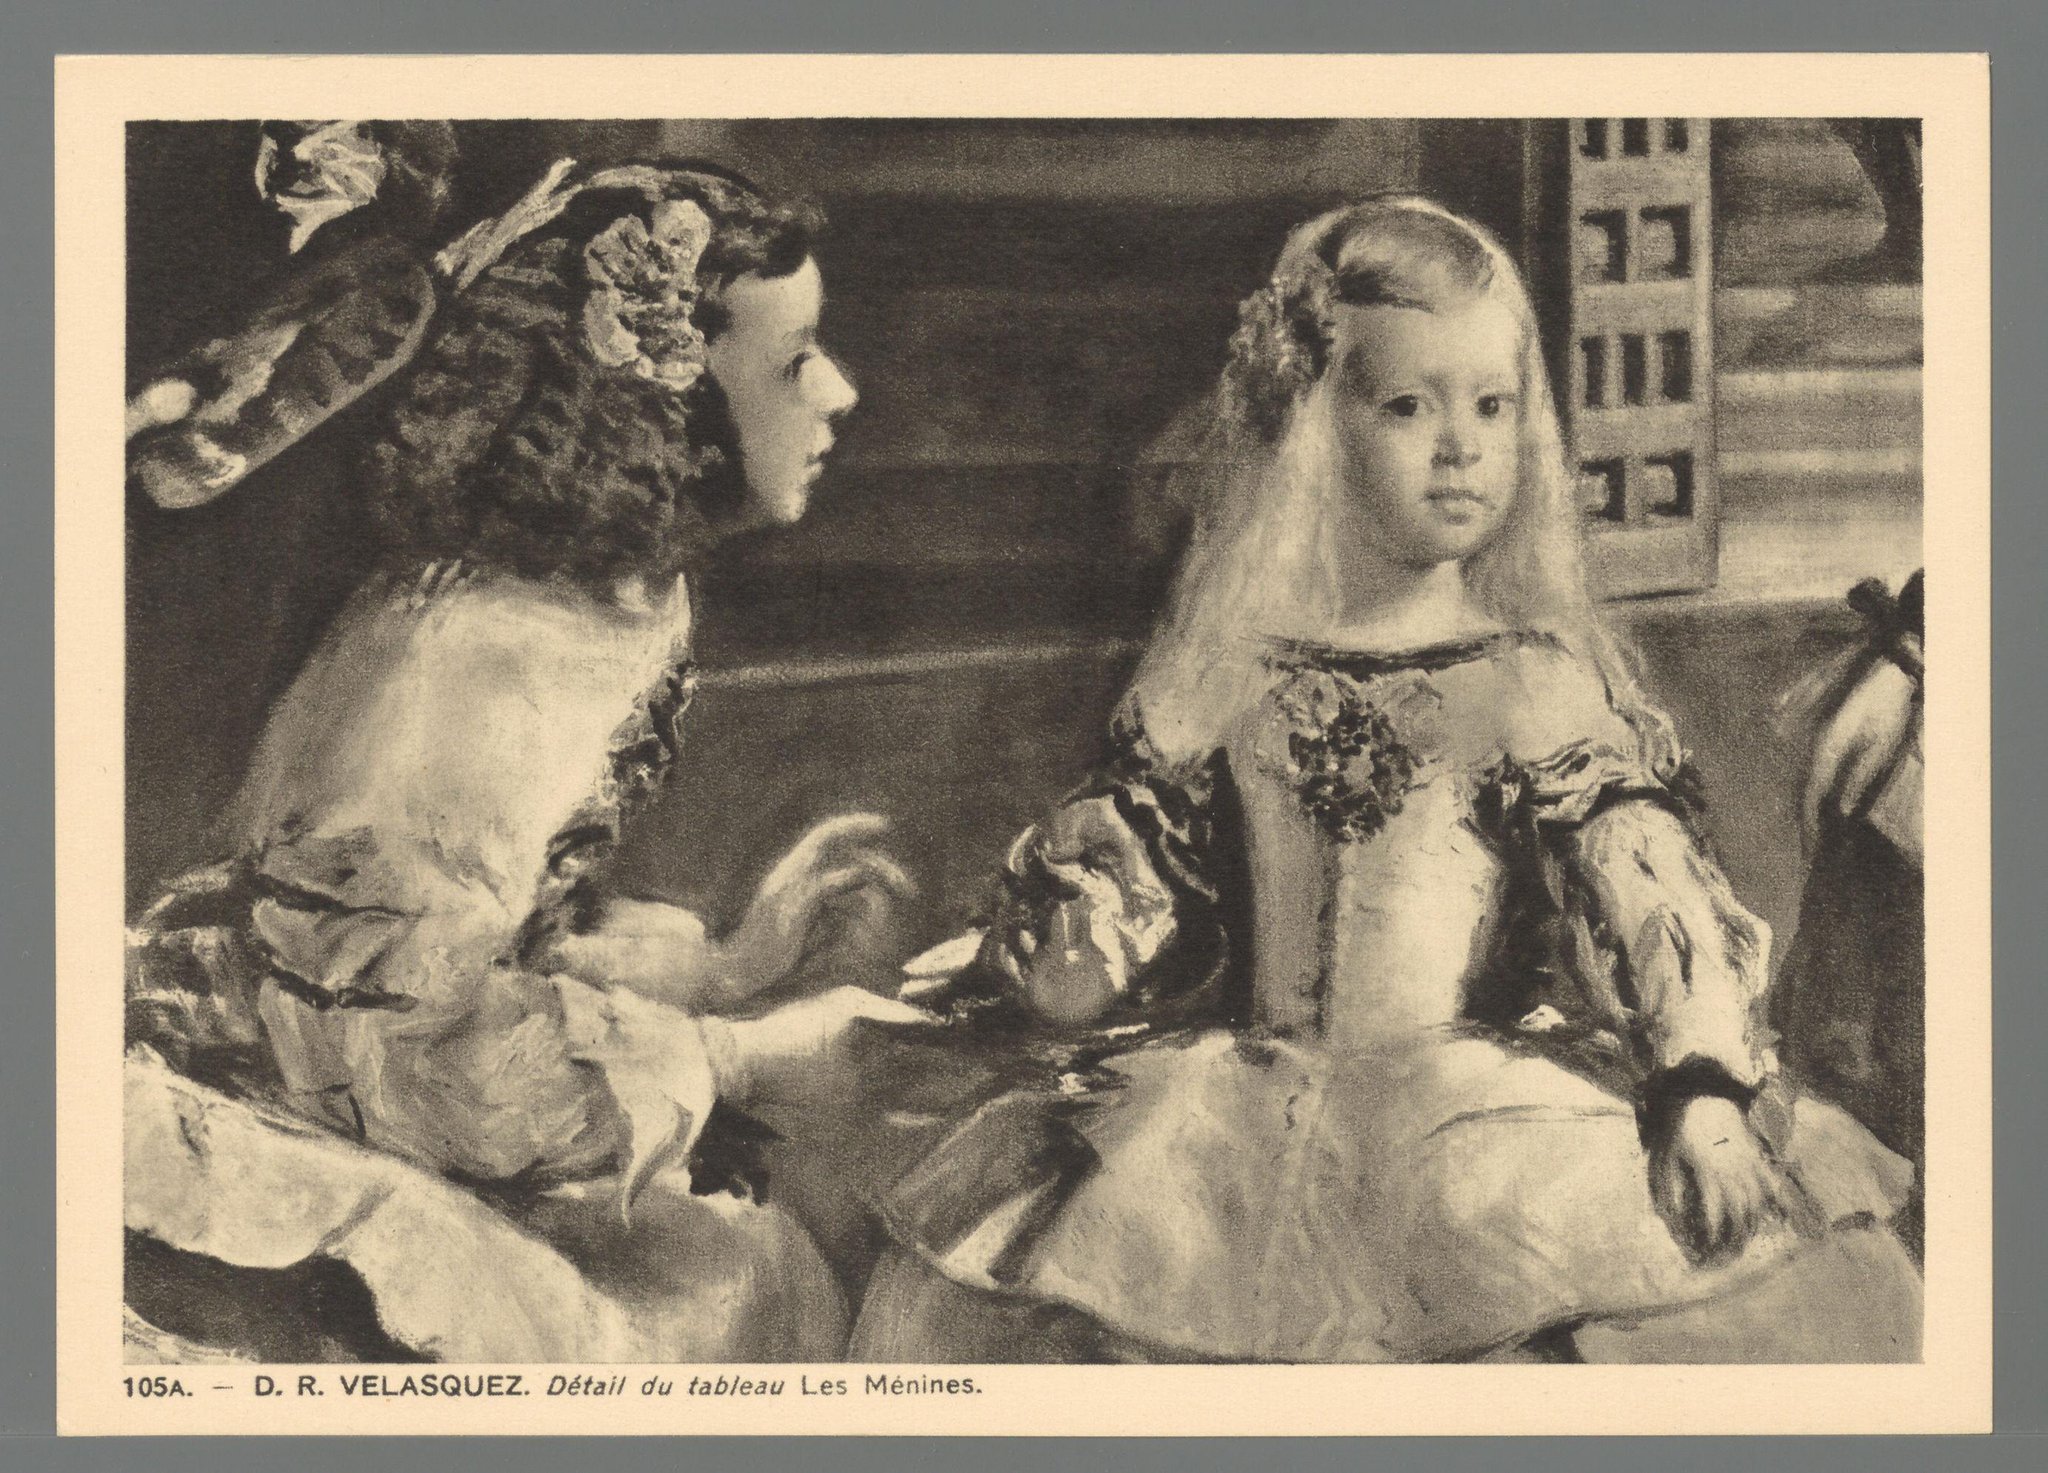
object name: reproduction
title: Détail du tableau Les Ménines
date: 1932-1940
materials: cardboard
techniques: rotogravure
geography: geneva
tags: girl (child between toddler and youth), royal household; courtiers, retinue, train